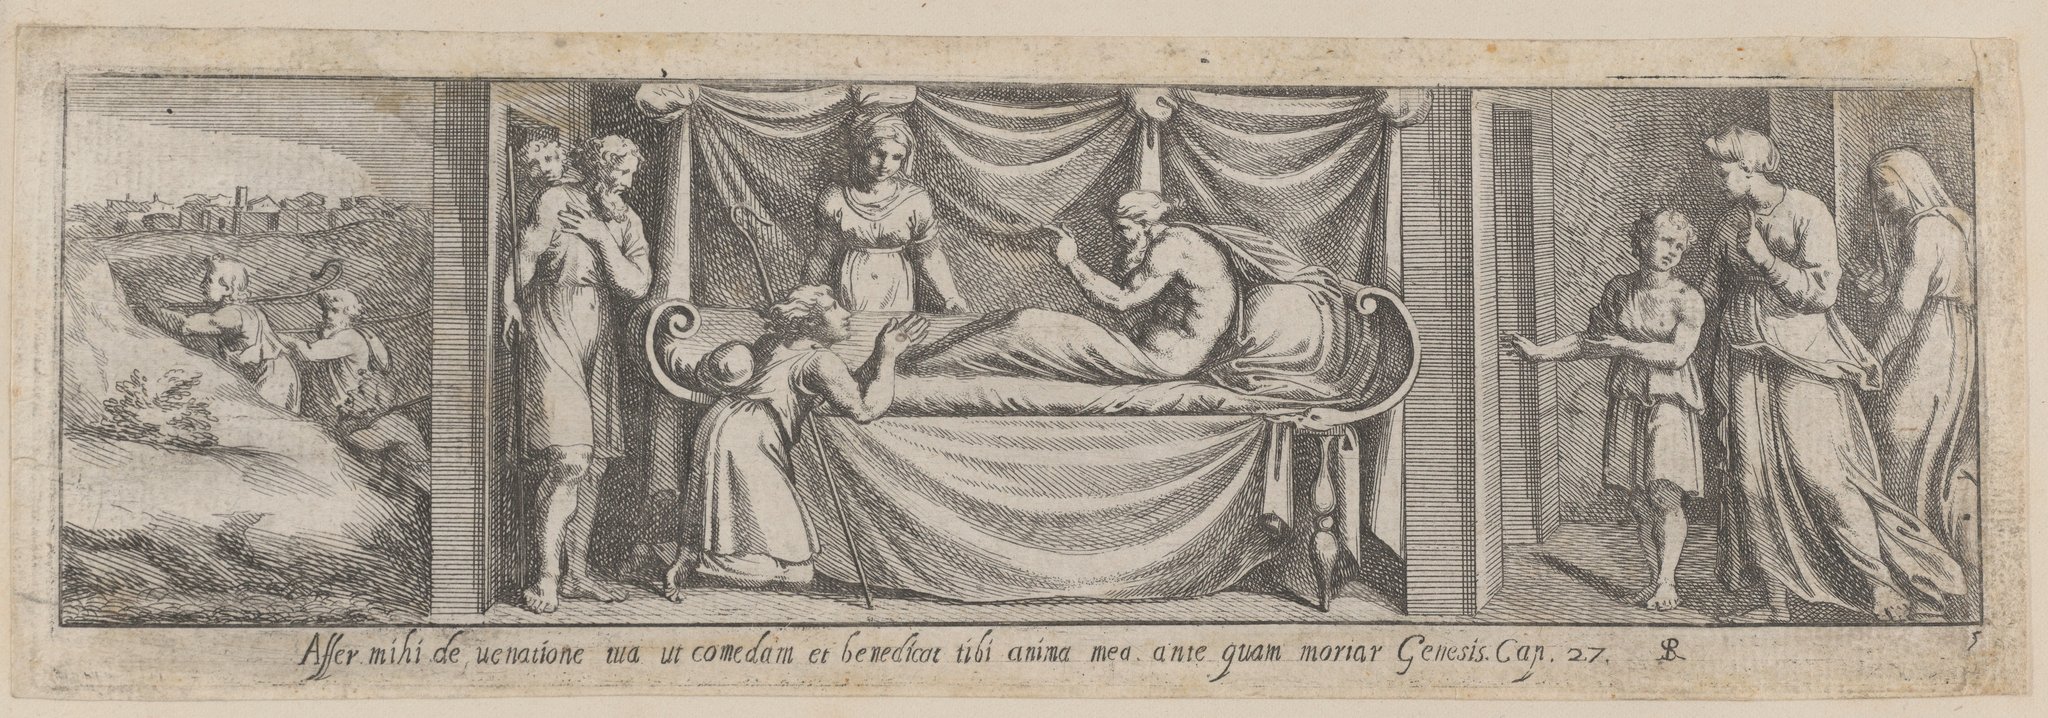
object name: print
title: Plate 5: Isaac telling Esau to hunt for meat at left and Jacob and Rebekah at right, from Genesis 27, after a lost fresco in the basamento of Bay 5 of the Vatican Loggia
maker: pietro santi bartoli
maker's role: artist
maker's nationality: italian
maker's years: 1615-1700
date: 1650-1677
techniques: etching